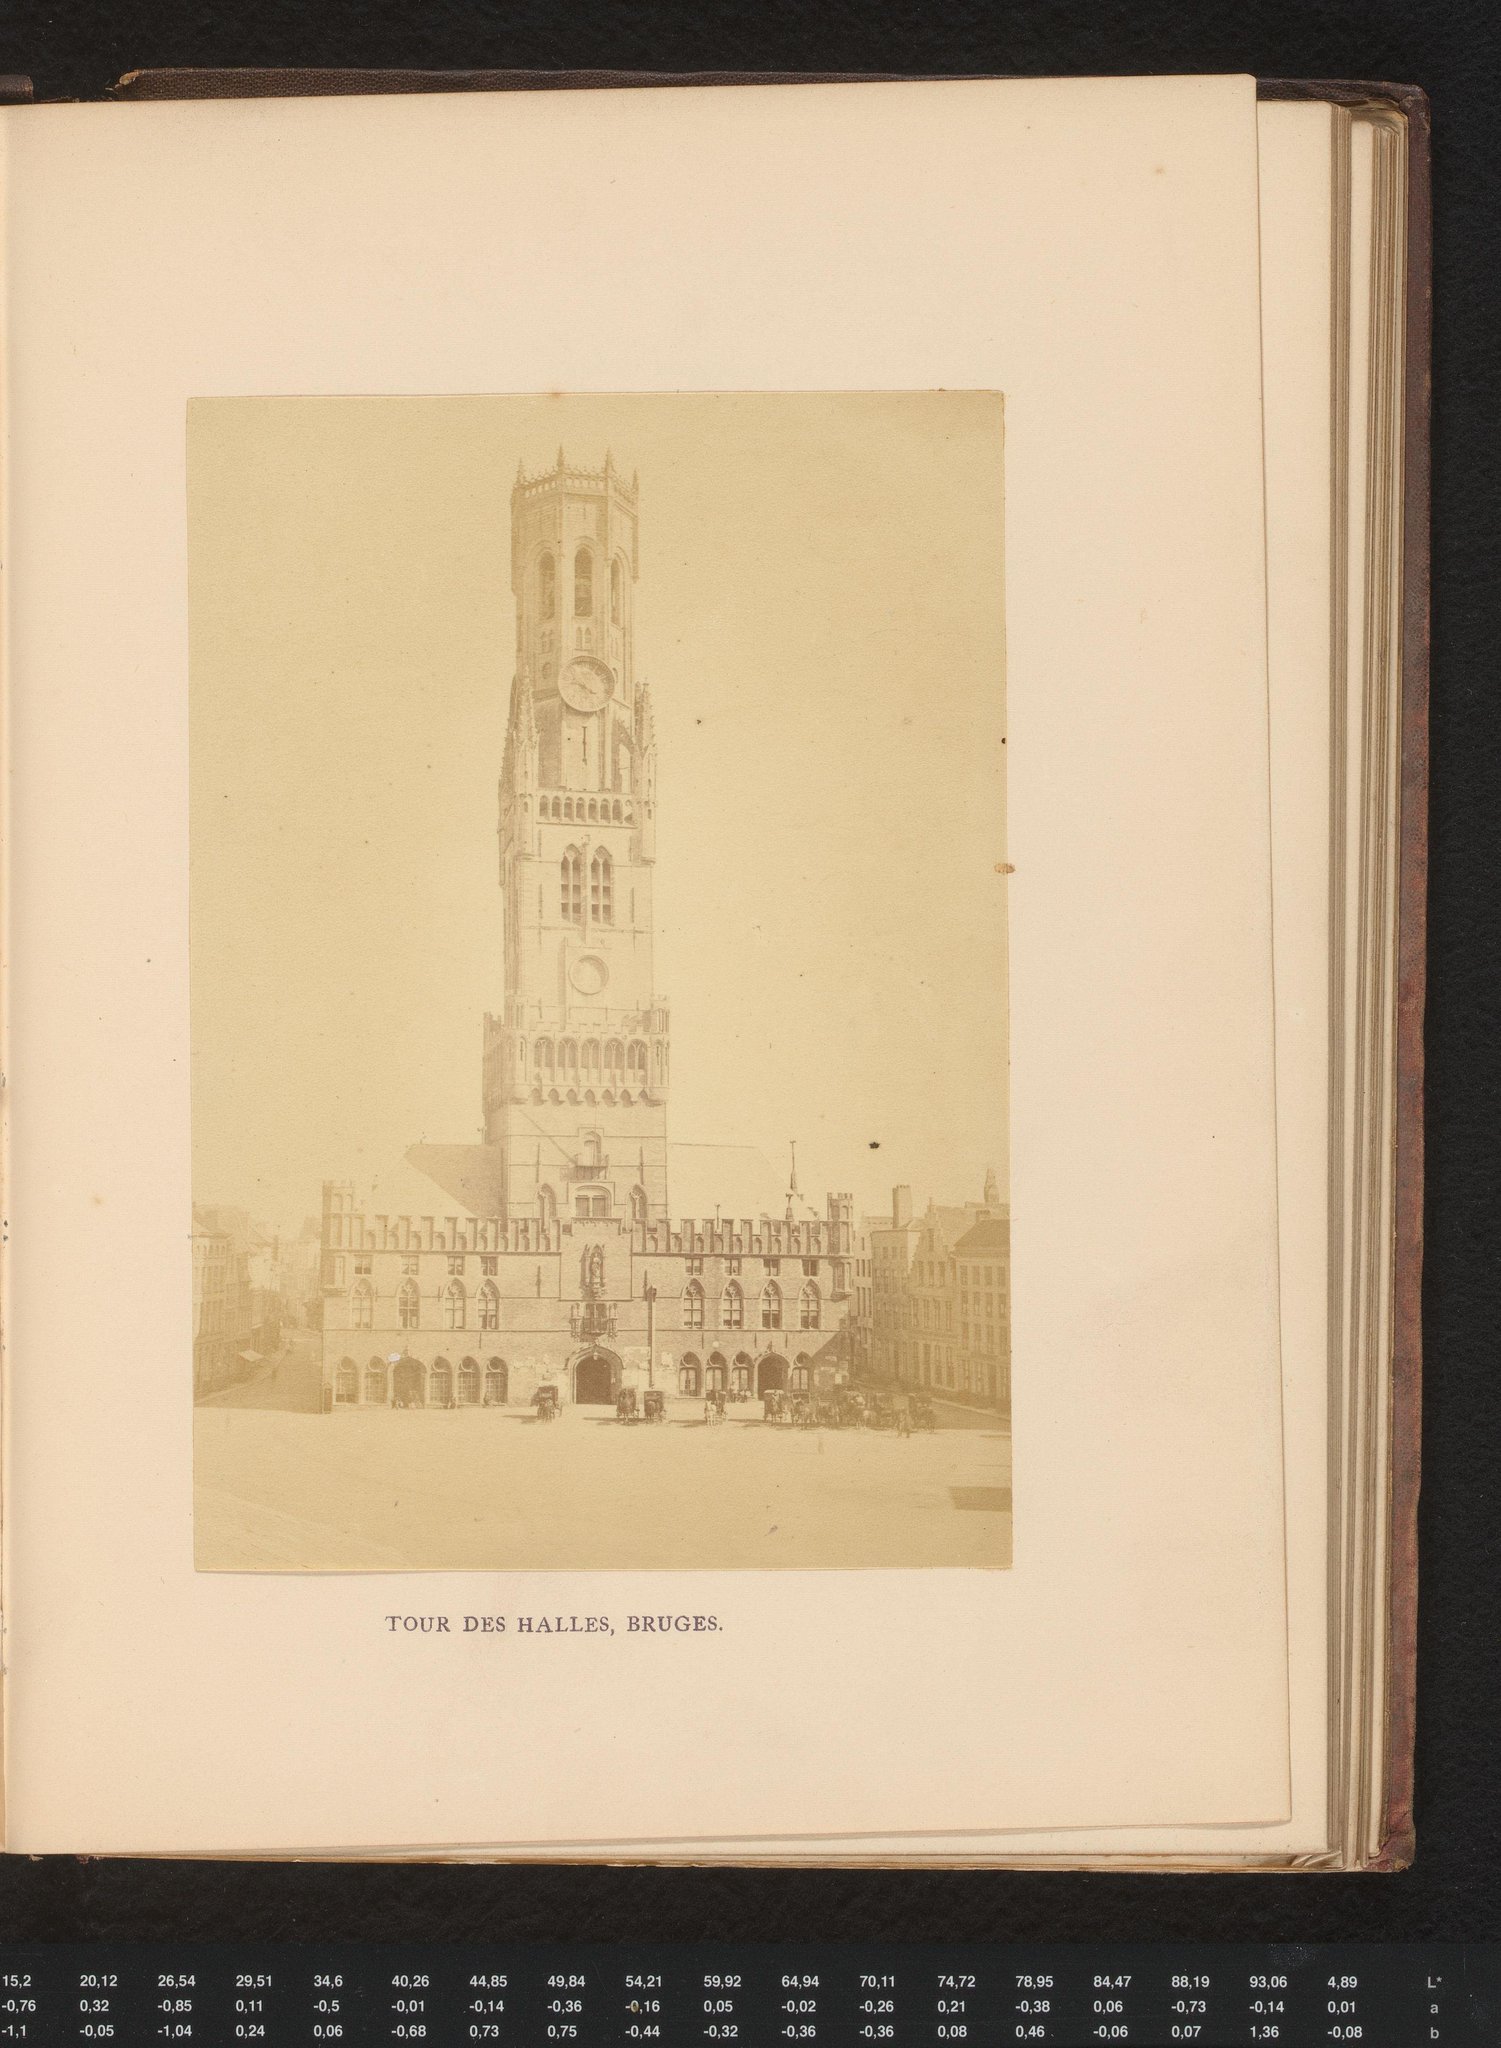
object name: page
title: Tour des Halles, Bruges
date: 1855-1866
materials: paper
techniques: albumen print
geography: bruges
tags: tower, clock tower ~ monumental adornment, bruges